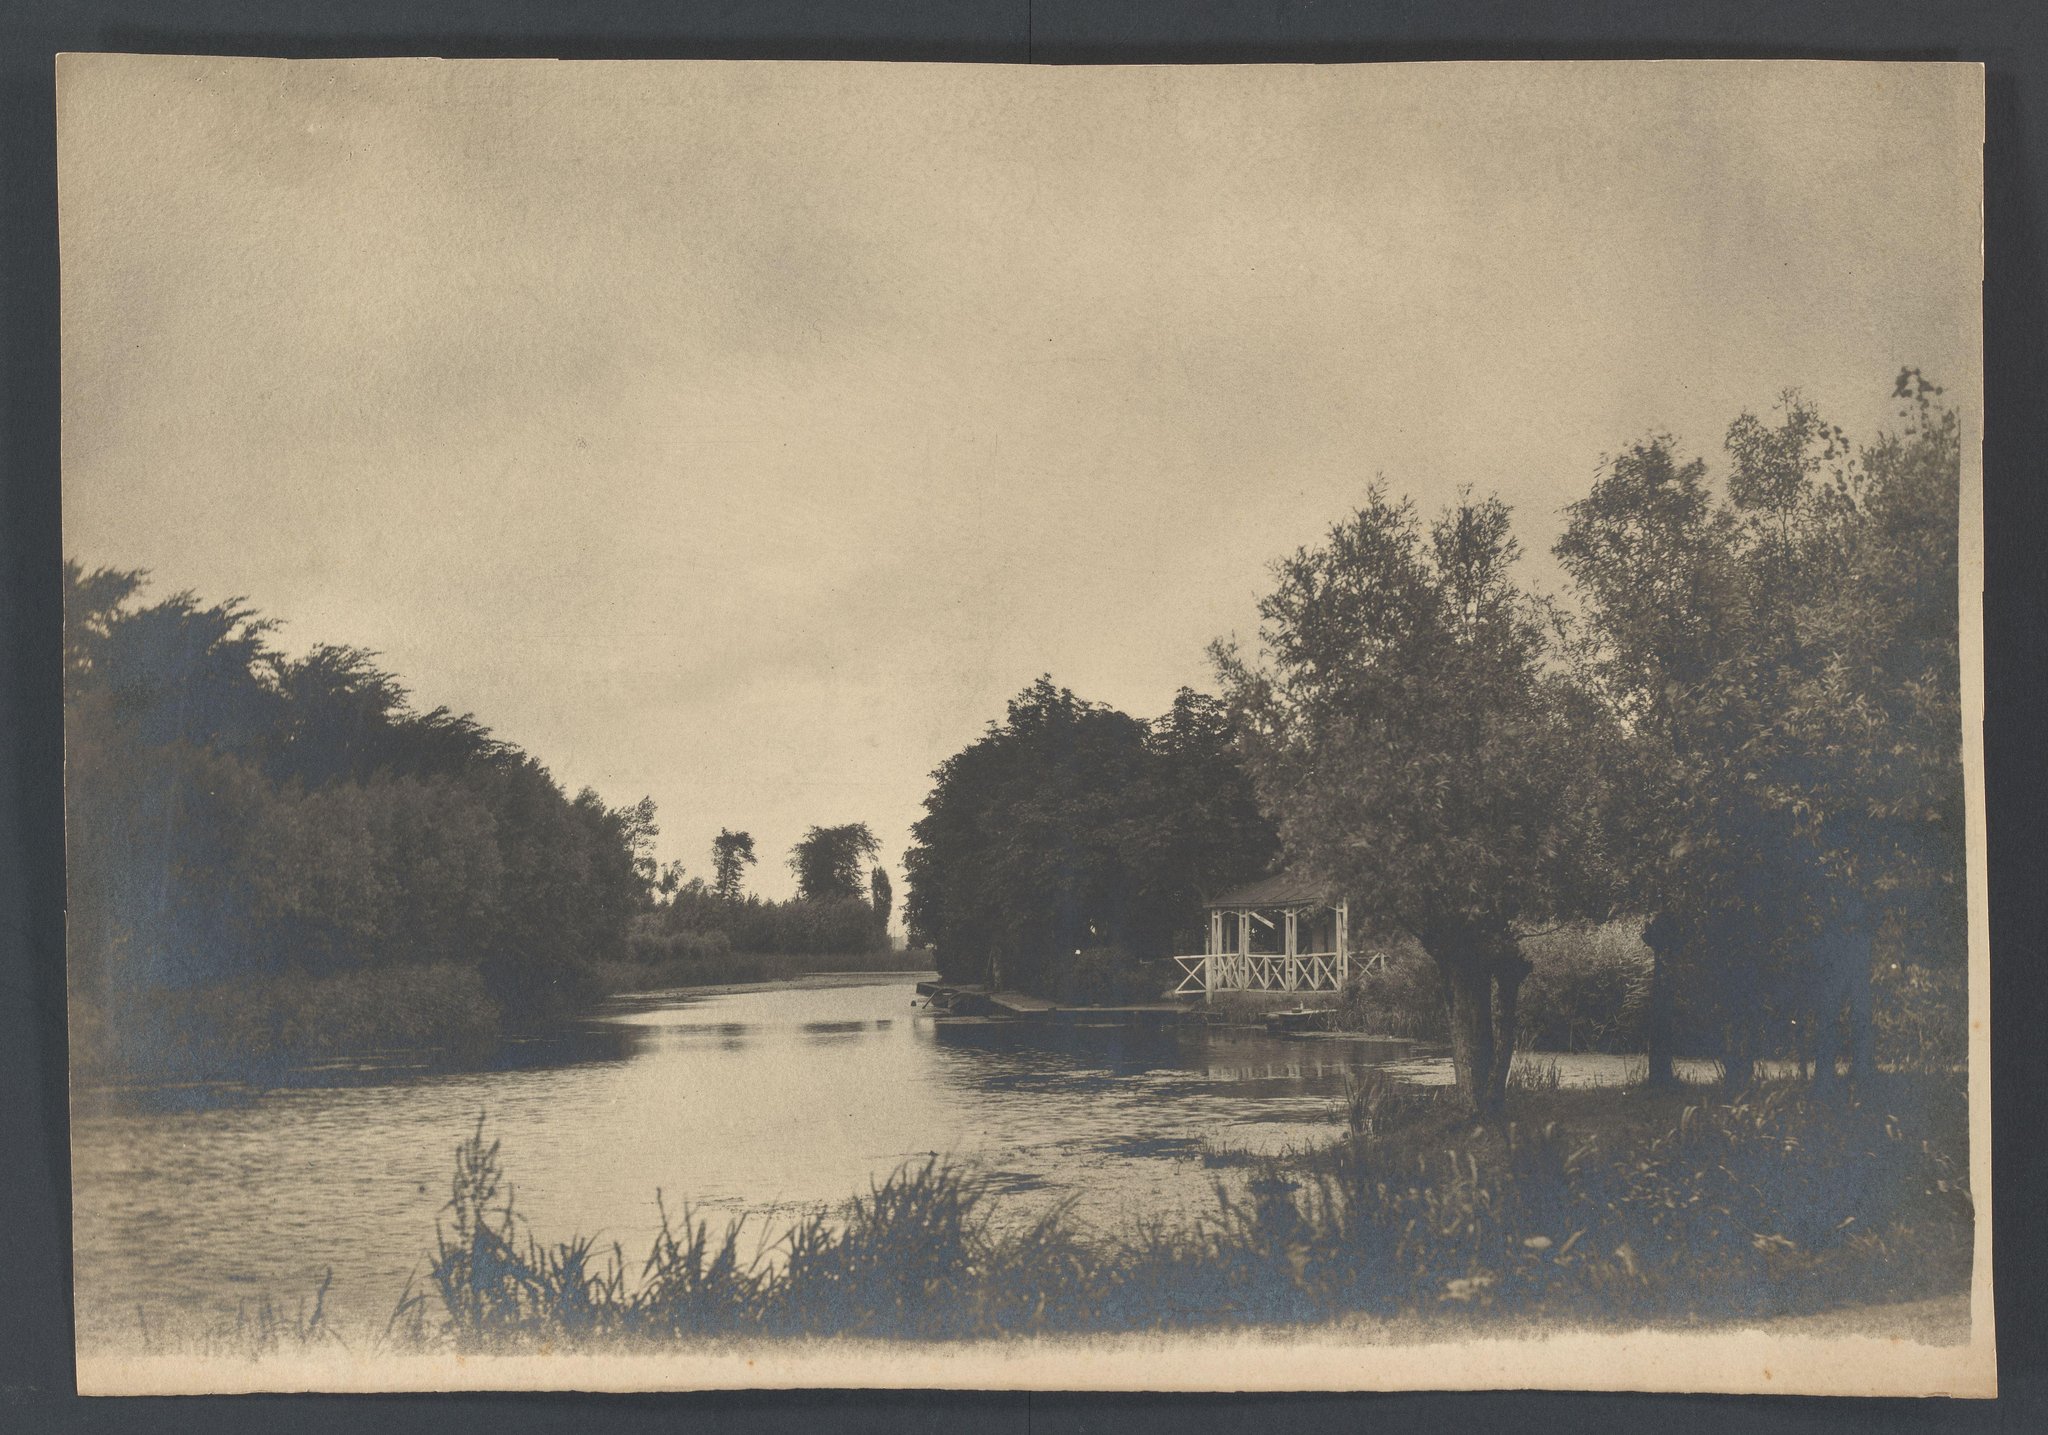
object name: photograph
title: Waterlandschap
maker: alb. kapteijn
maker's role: amateurfotograaf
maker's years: 1848-1927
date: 1900-1925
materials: paper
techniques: gelatin silver print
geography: netherlands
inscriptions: annotation: ‘9 à 10 T / [...] 10 à 11’